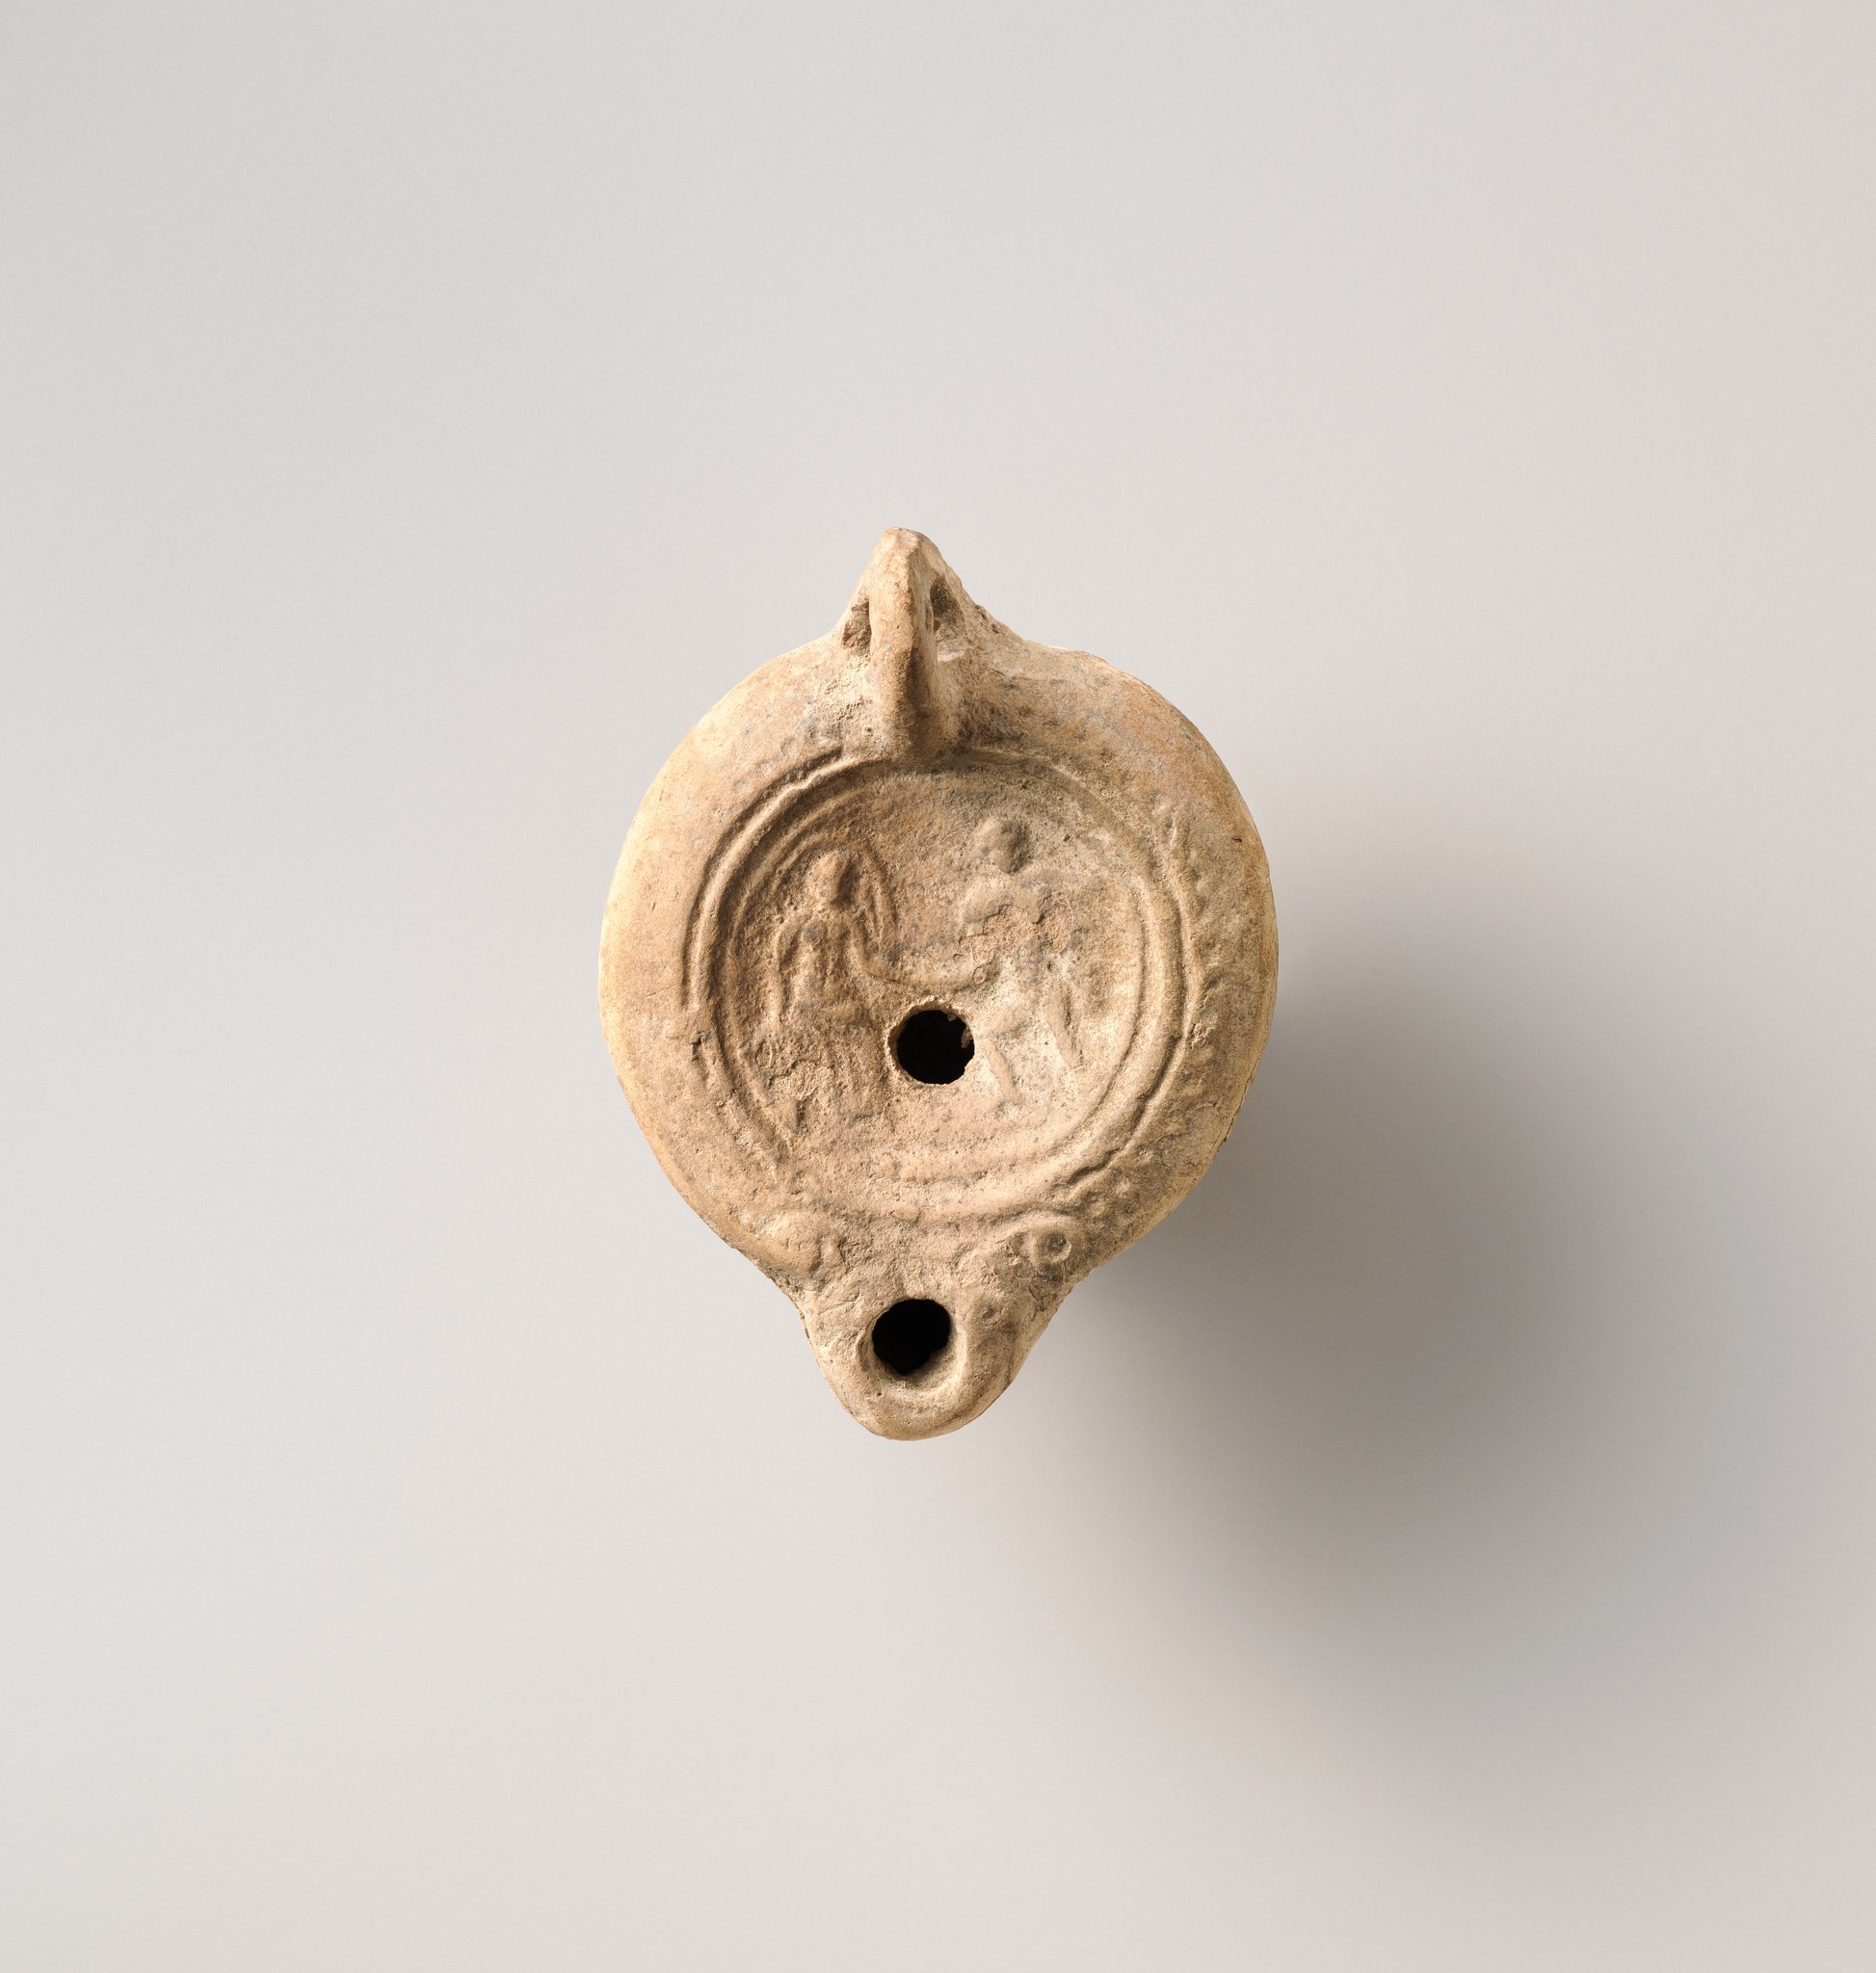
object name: lamp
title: Terracotta oil lamp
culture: roman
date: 101-200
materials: terracotta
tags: men,women